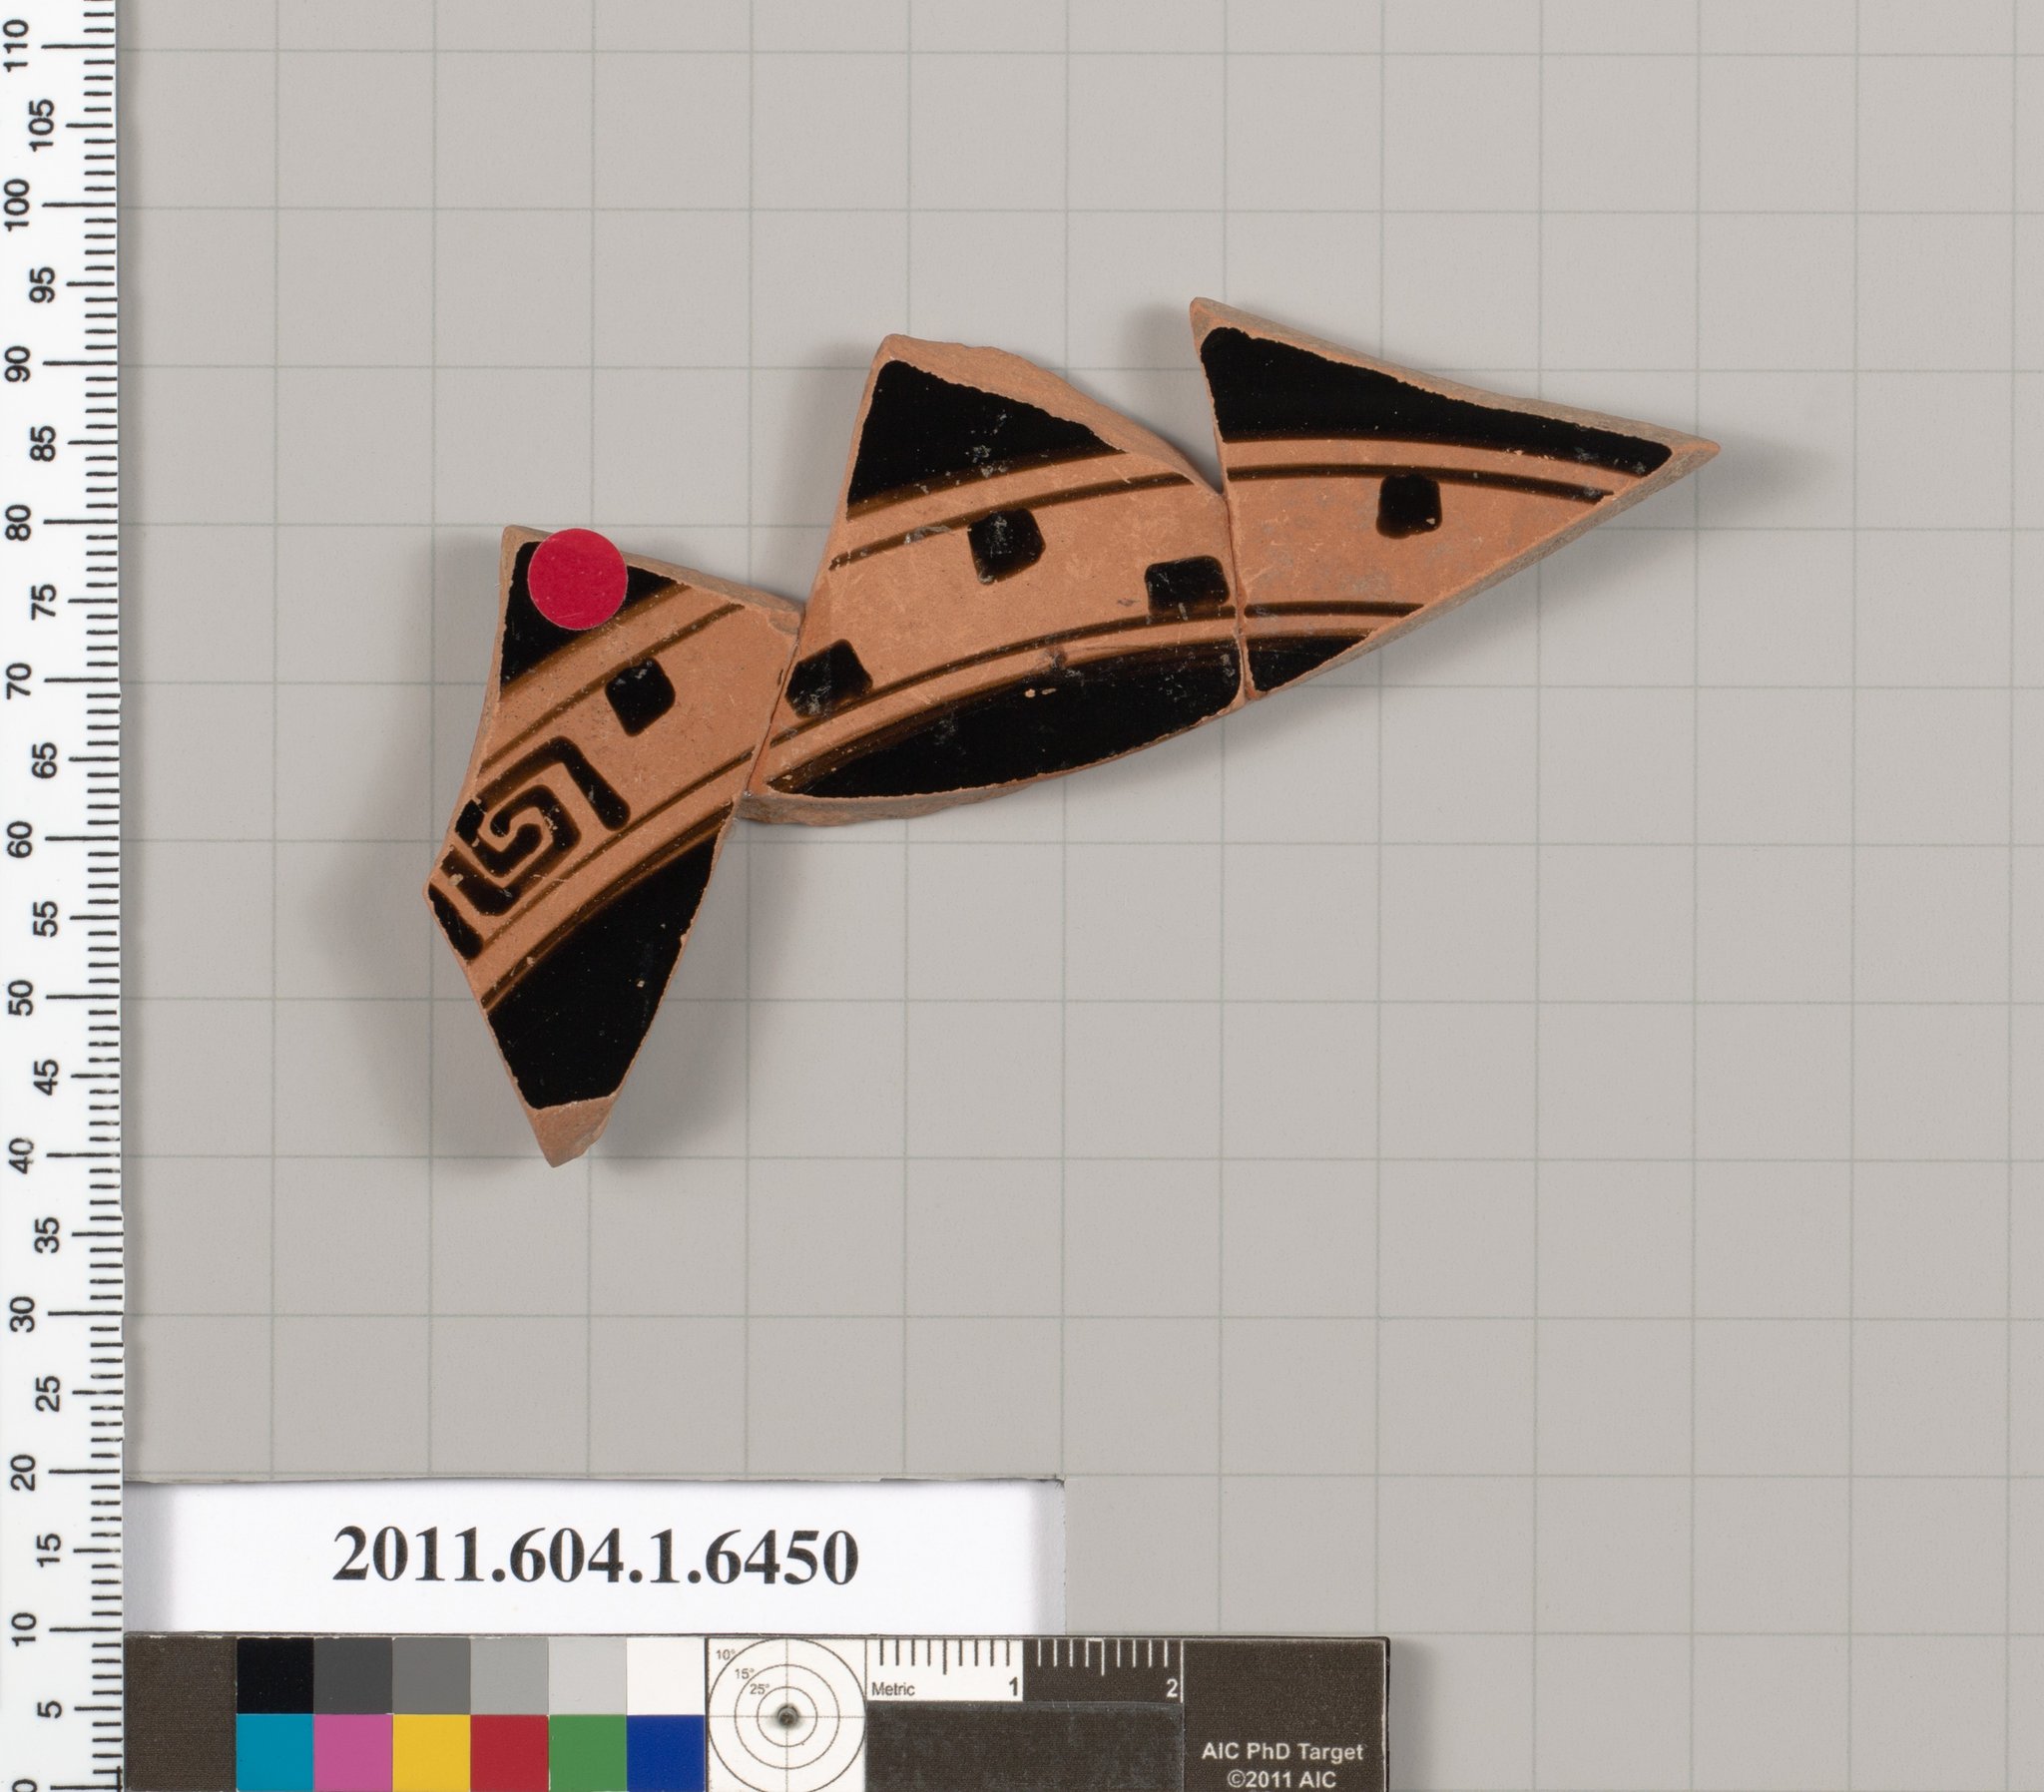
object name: kylix fragment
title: Terracotta fragment of a kylix (drinking cup)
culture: greek, attic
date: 490-480 BCE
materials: terracotta